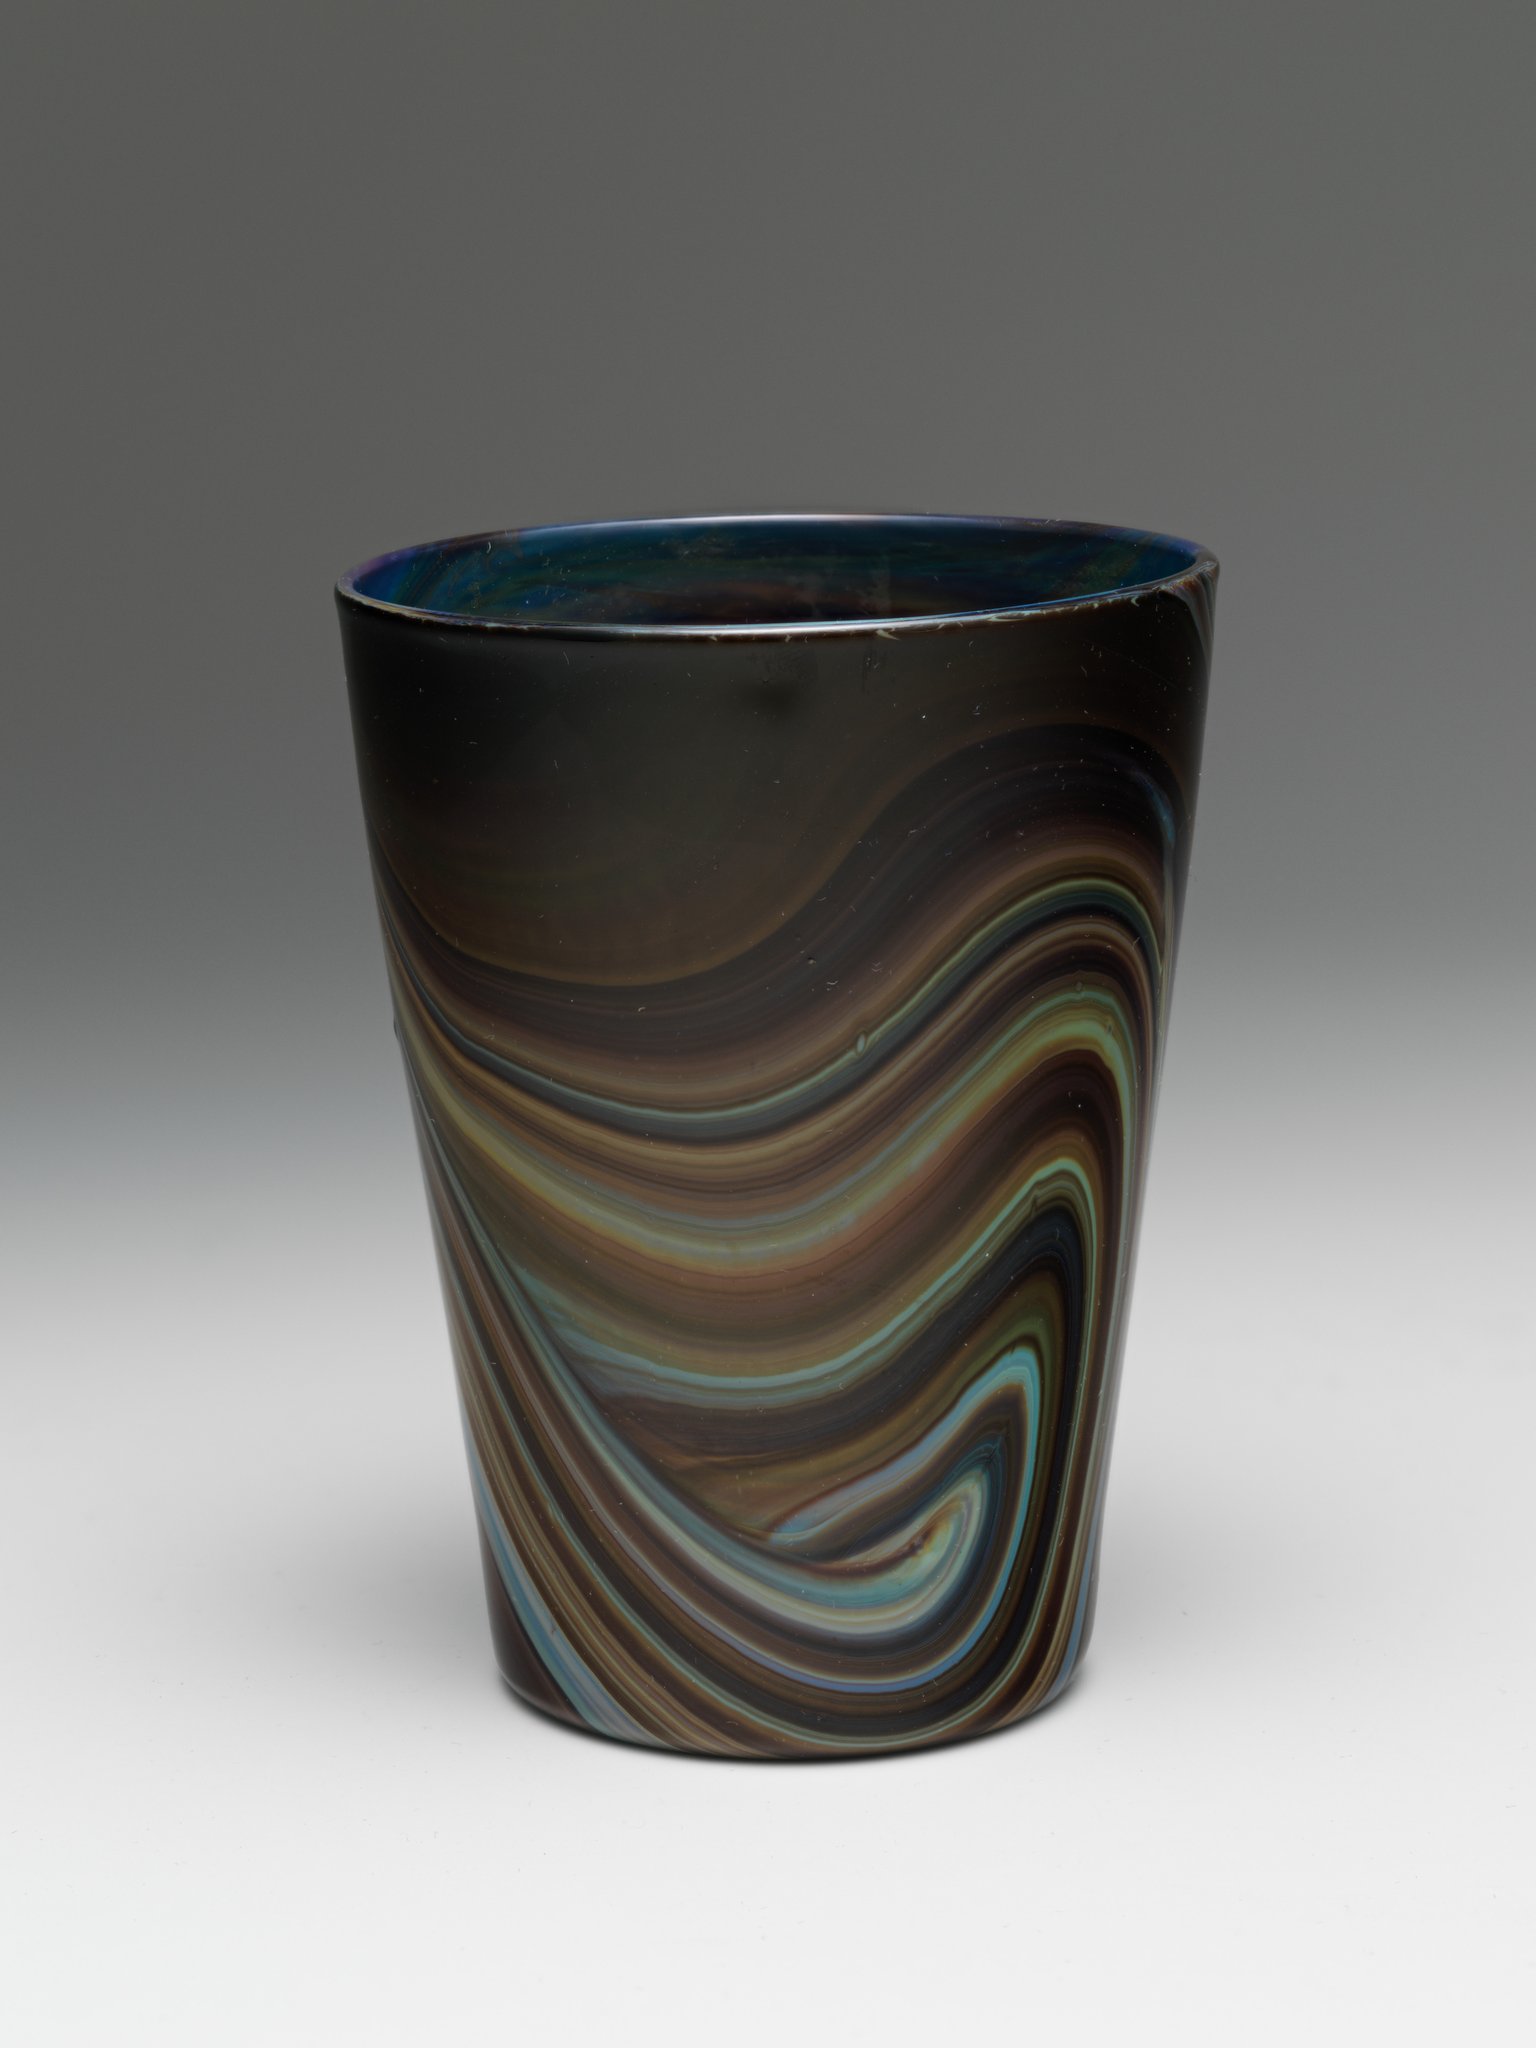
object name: beaker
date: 1701-1900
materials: glass